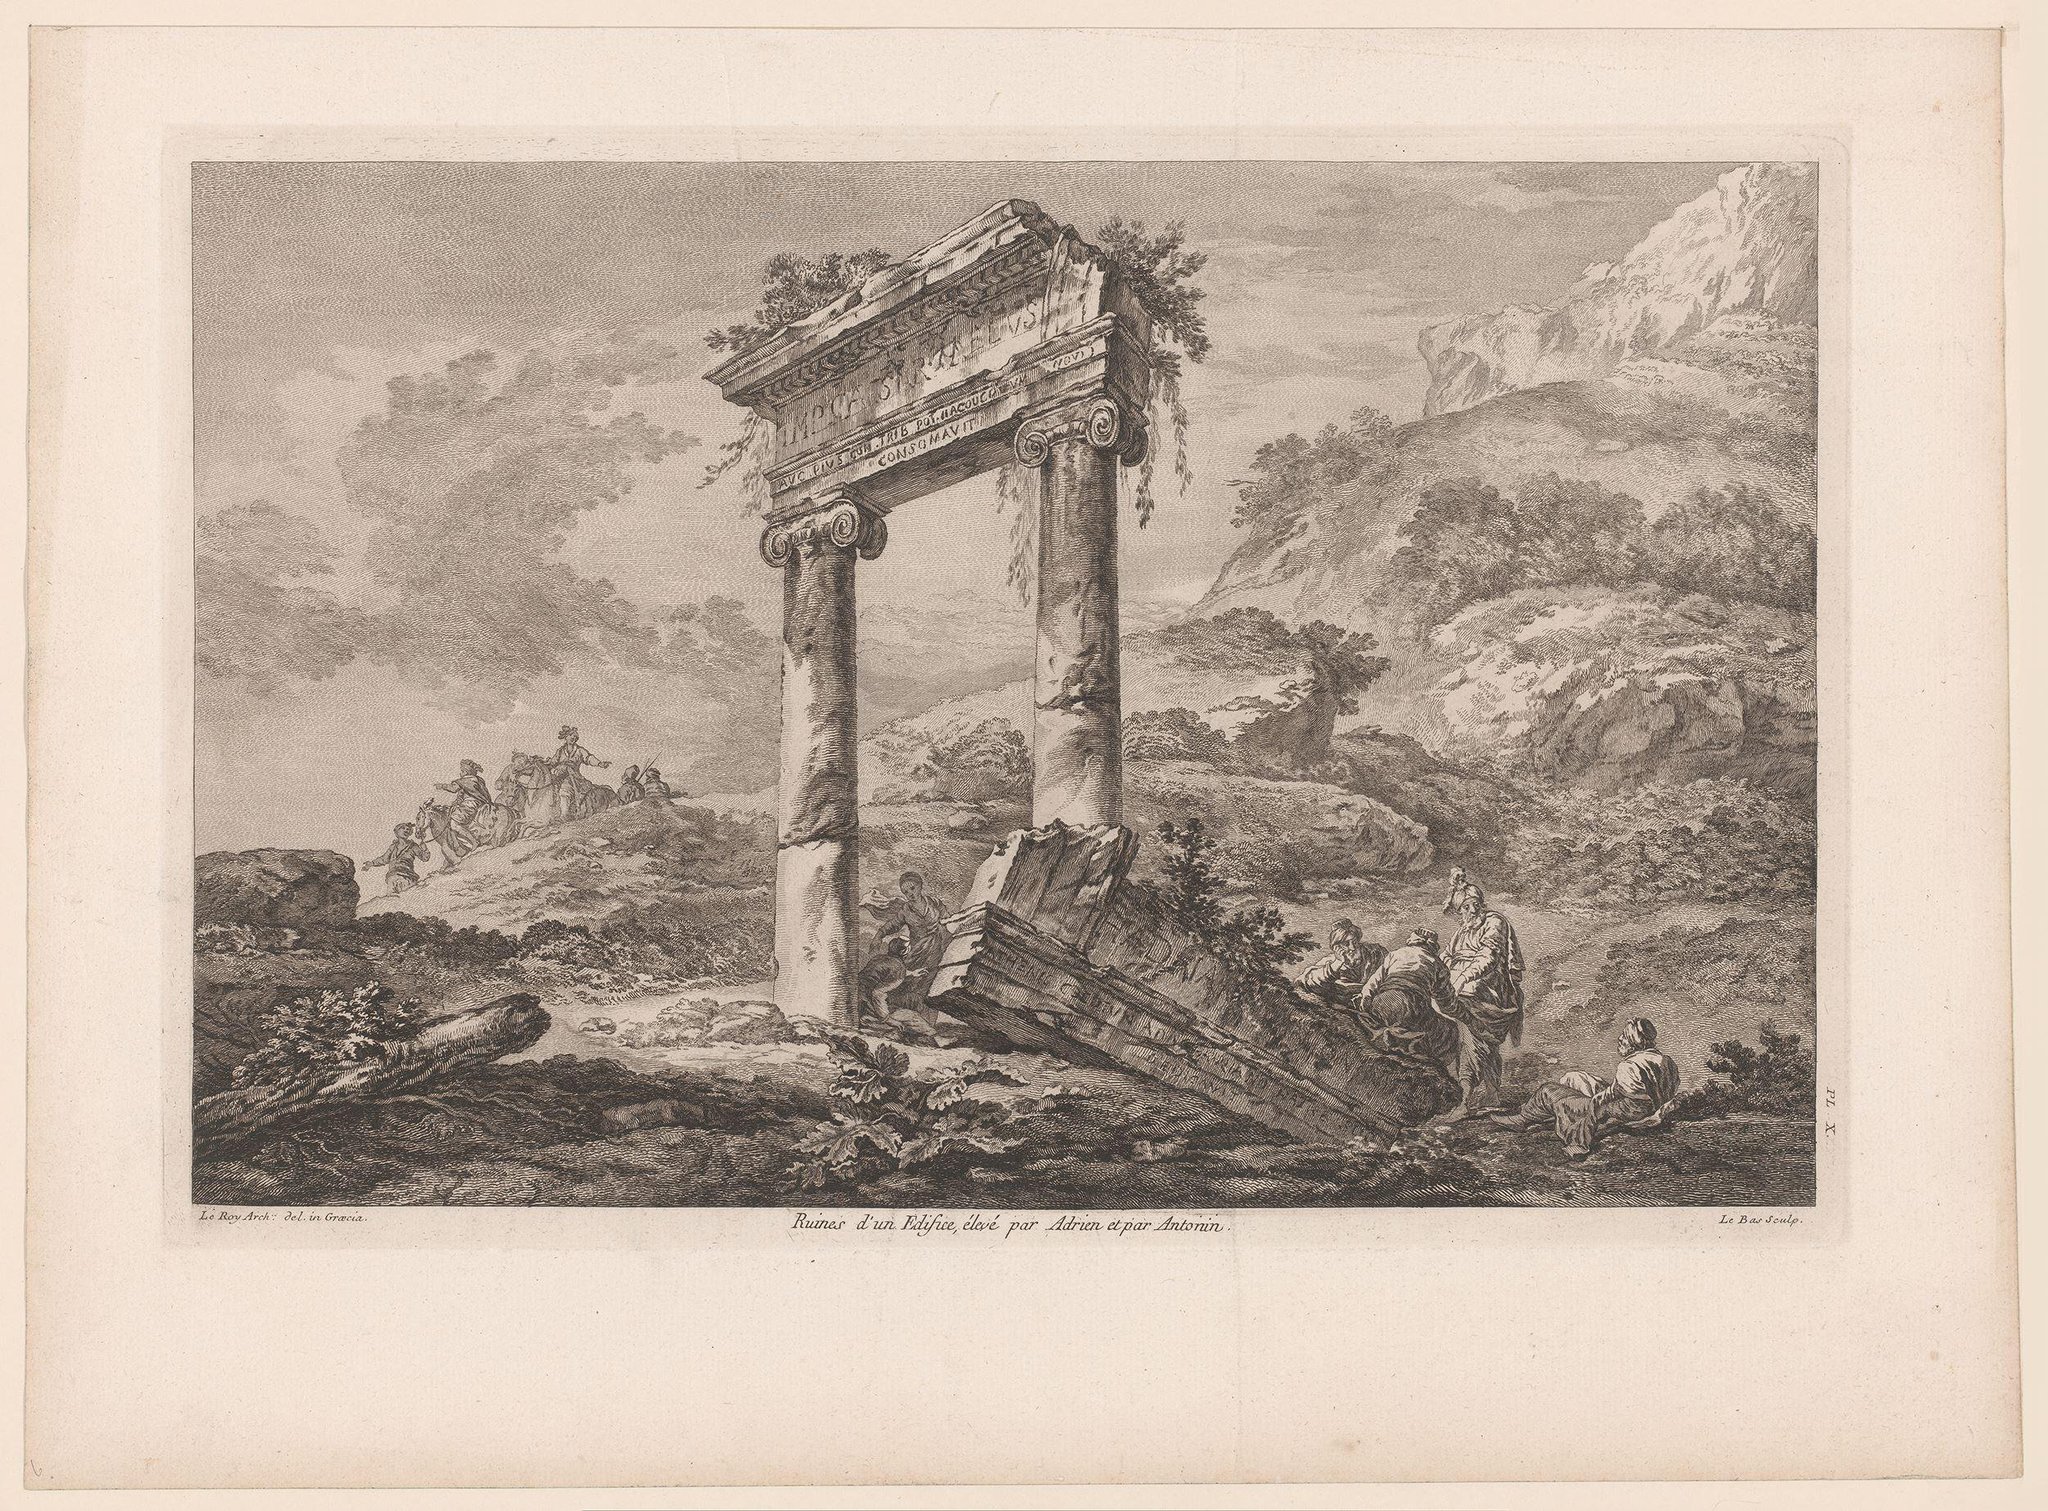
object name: book illustration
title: Gezicht op een ruïne in een landschap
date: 1758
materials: paper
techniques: etching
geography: paris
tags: ruin of a building ~ architecture, landscape with ruins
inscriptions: collector's mark: Lugt 2760, collector's mark: Lugt 2228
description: Prent uit: Le Roy, Julien. Ruines des plus beaux monuments de la Grêce. Parijs: Guérin & de La Tour, 1758. Dit betreft plaat X.